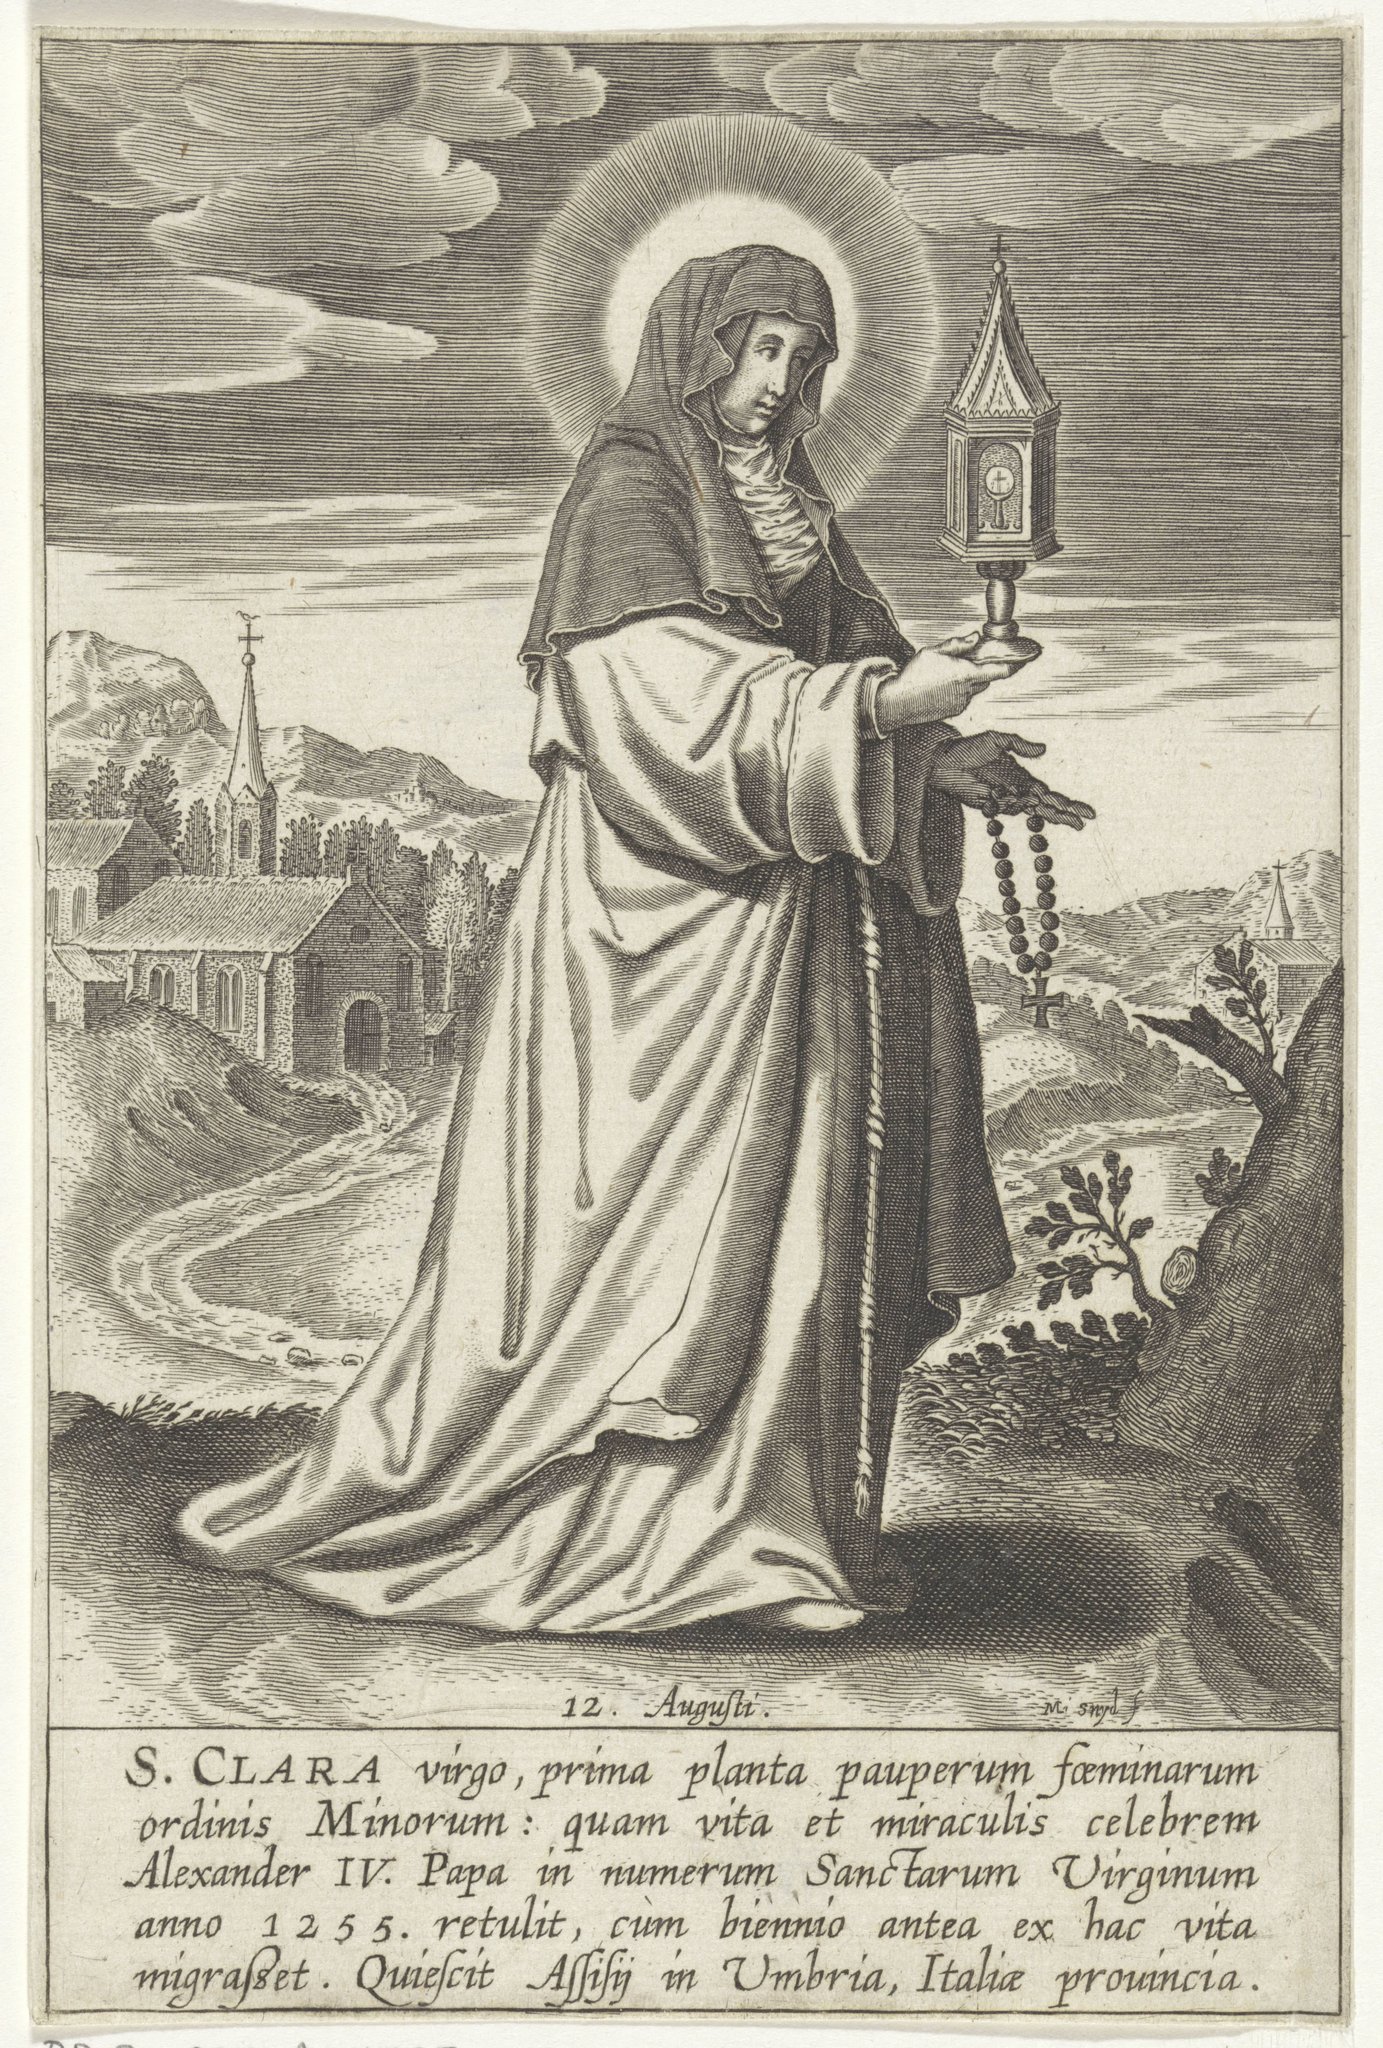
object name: print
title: Heilige Clara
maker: michael snijders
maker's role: print maker, publisher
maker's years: 1586-1672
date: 1610-1672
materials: paper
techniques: engraving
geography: antwerp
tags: the virgin and foundress of the order of minoresses (or poor clares), clare of assisi; possible attributes: book, cross, flaming horn, lily, monstrance, palm-branch, pastoral staff, rosary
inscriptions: collector's mark: Lugt 2228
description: De heilige Clara met monstrans en rozenkrans in de hand. Achter haar een kapel in een berglandschap. Onderaan de prent wordt als haar feestdag 12 augustus genoemd. Daaronder een korte verklaring in het Latijn over haar leven en sterven.